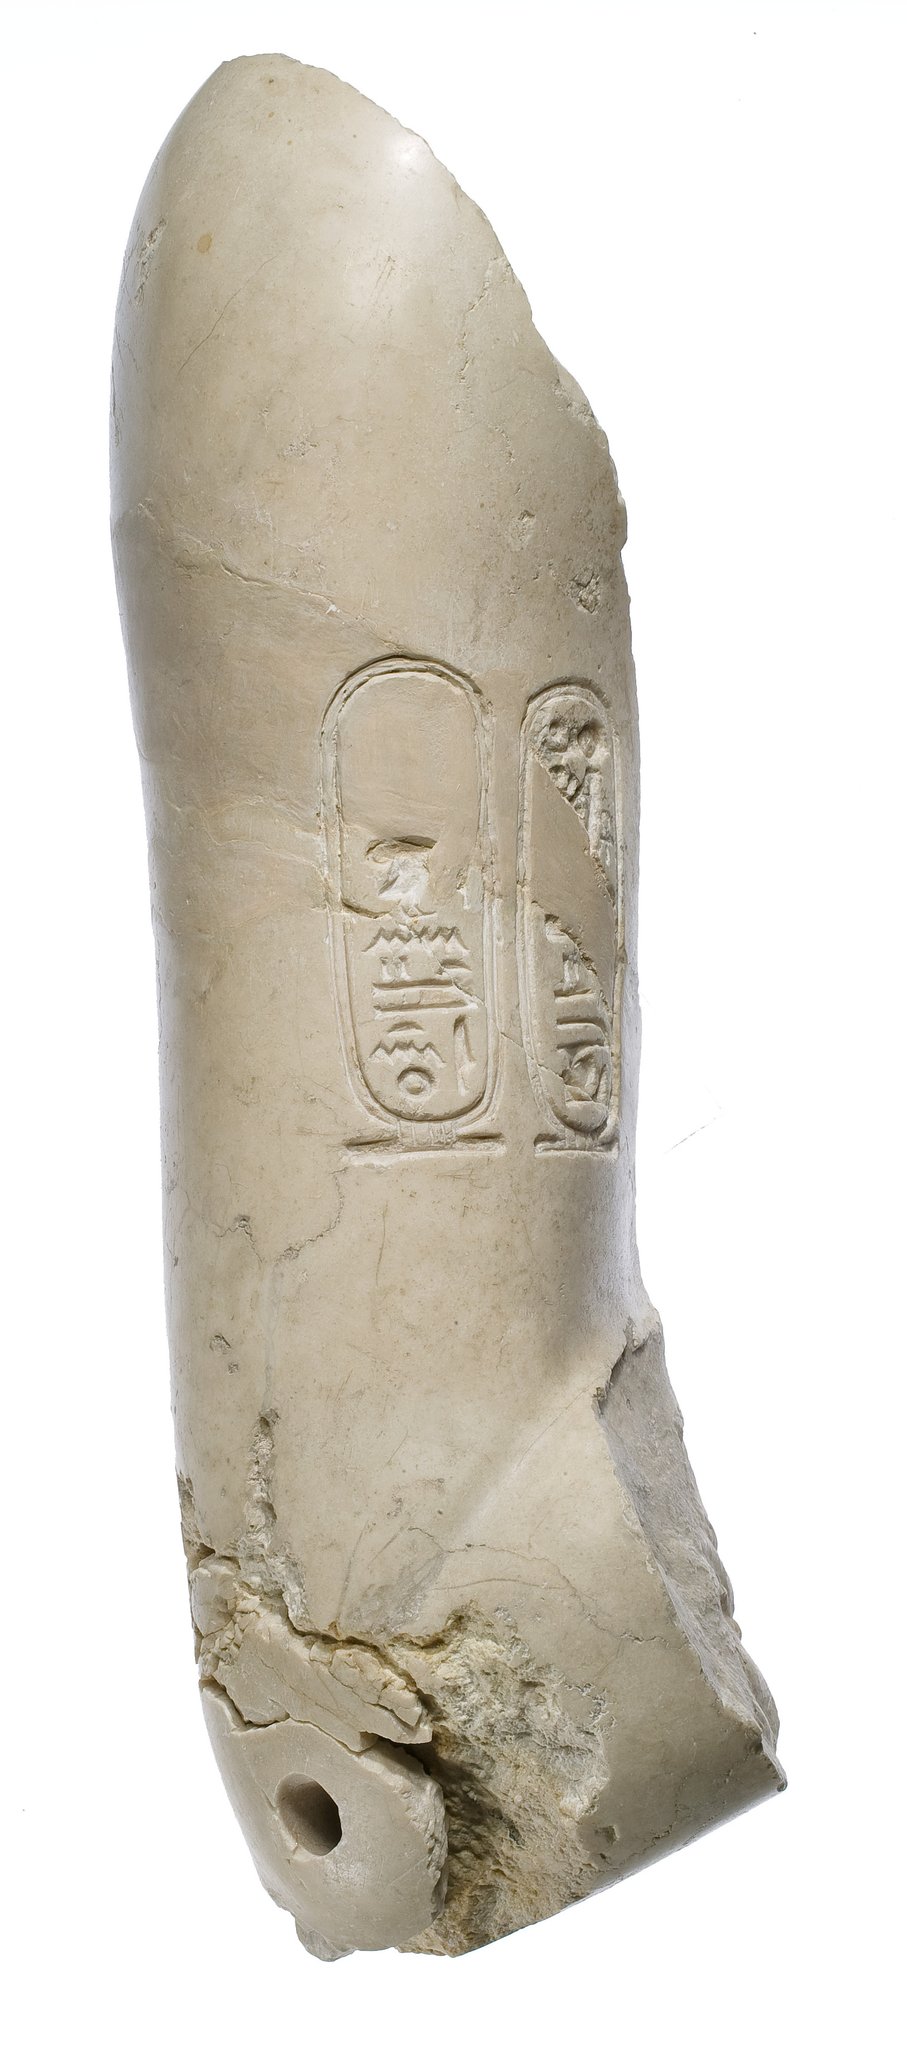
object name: arm, aten cartouch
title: Upper right arm, bent, Aten cartouches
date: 1353-1336 BCE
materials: limestone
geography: egypt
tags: cartouches